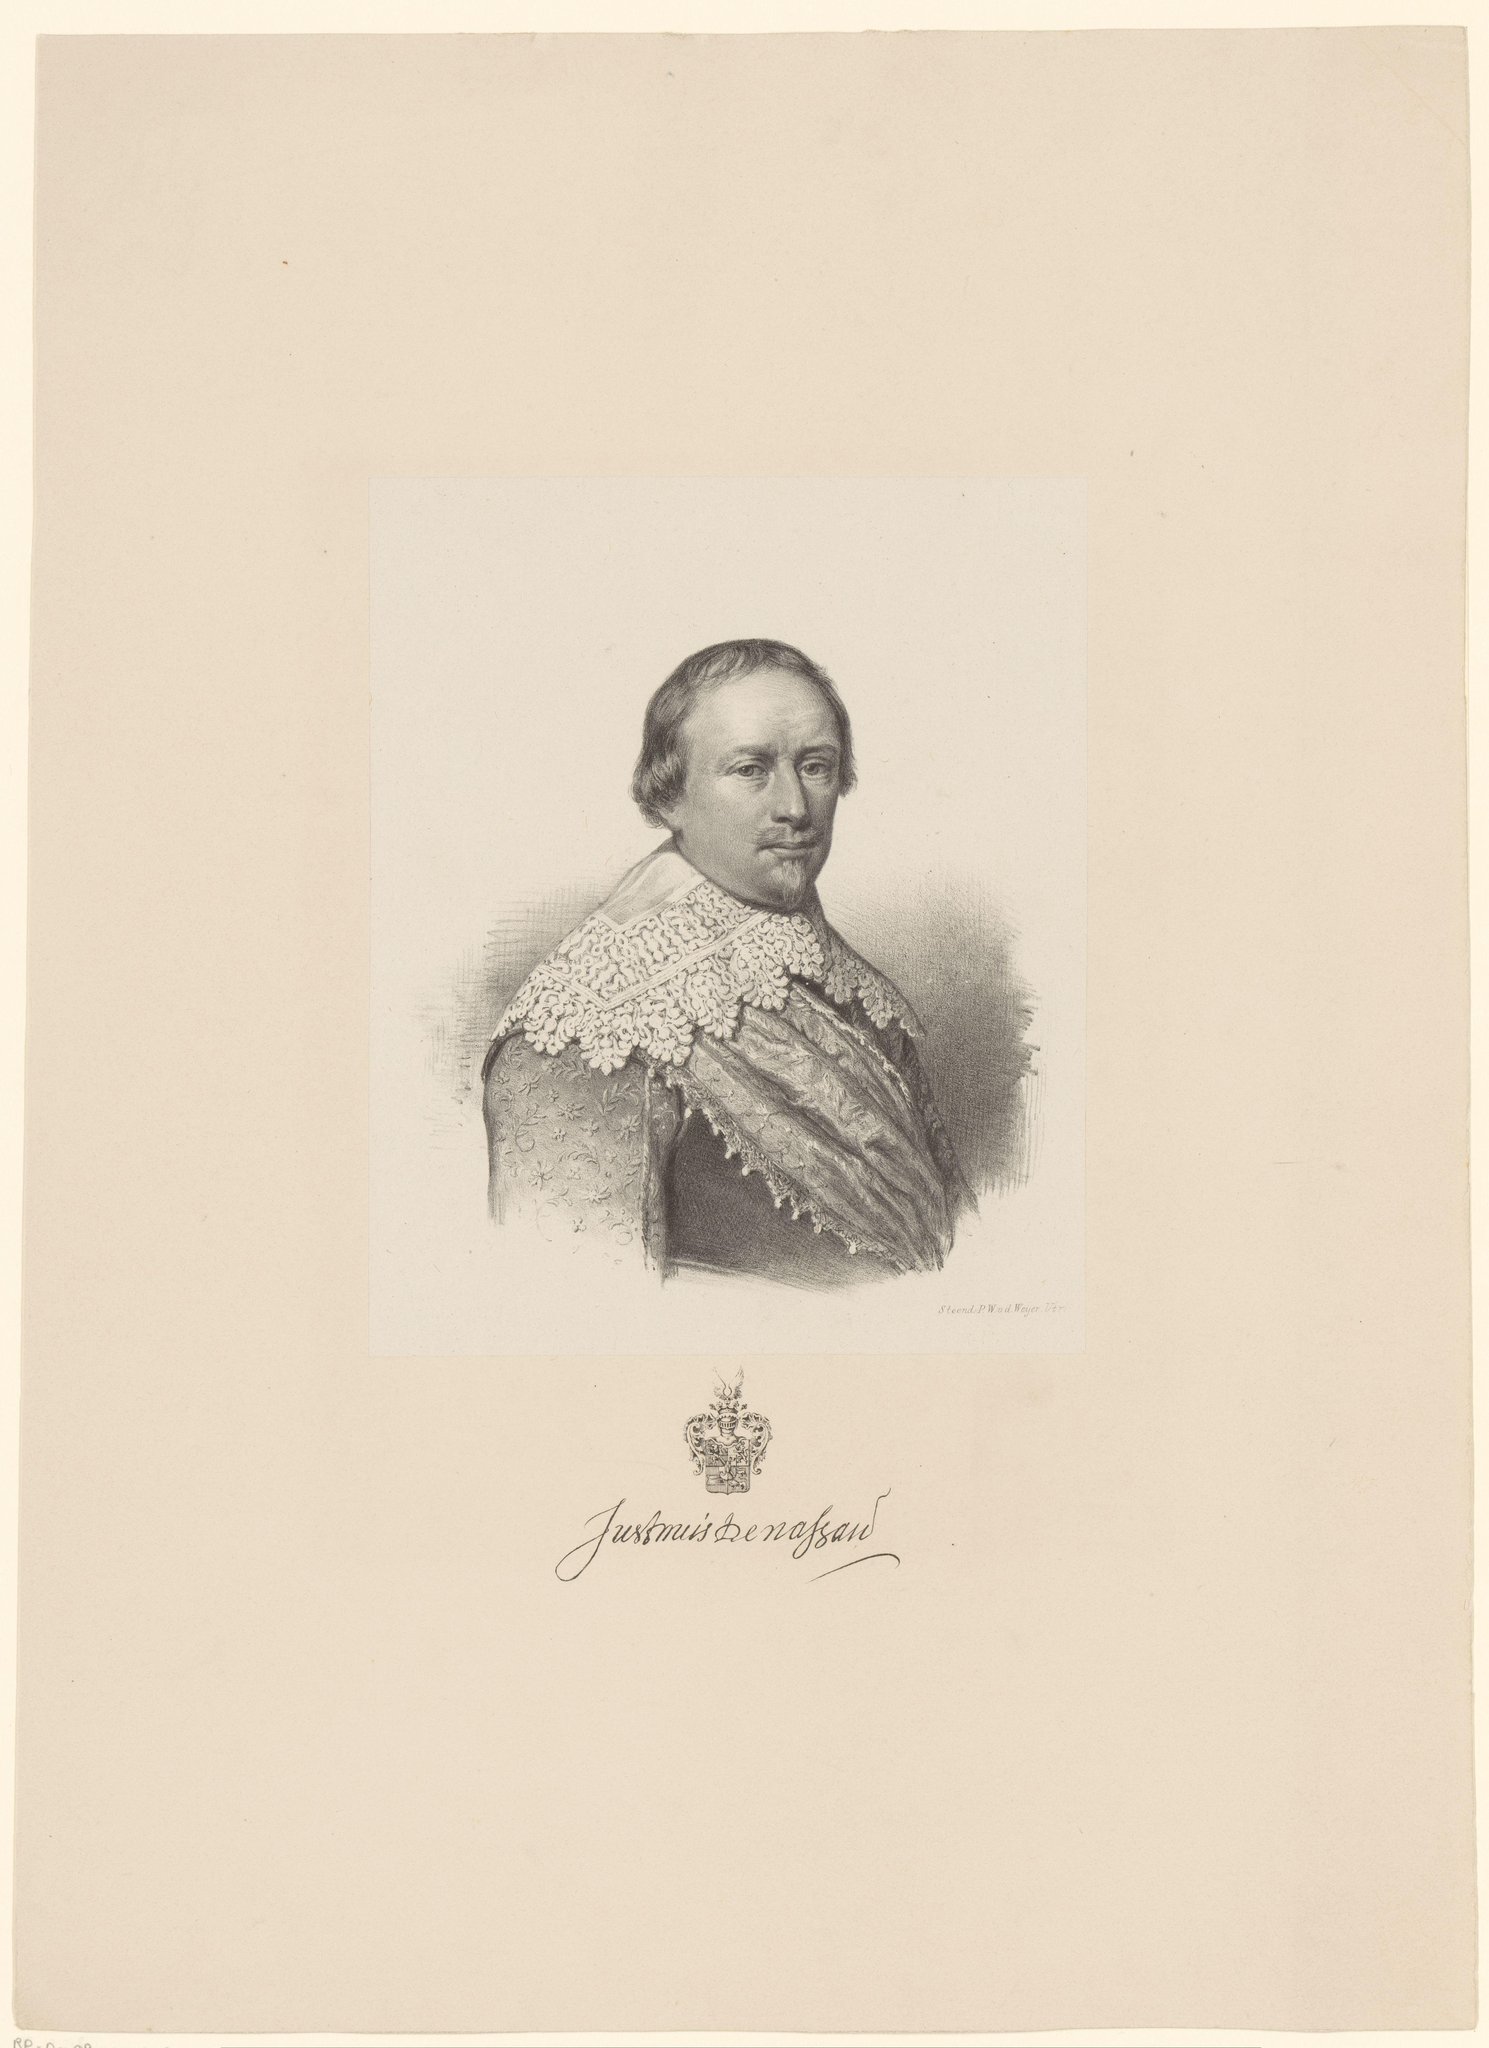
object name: print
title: Portret van Justinus van Nassau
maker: pieter wilhelmus van de weijer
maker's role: print maker, printer, publisher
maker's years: 1816-1880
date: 1826-1880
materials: paper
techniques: lithograph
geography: utrecht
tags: historical persons (+ (full) bust portrait)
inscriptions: collector's mark: Lugt 2228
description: Onder het portret het wapen en de signatuur van de geportretteerde.